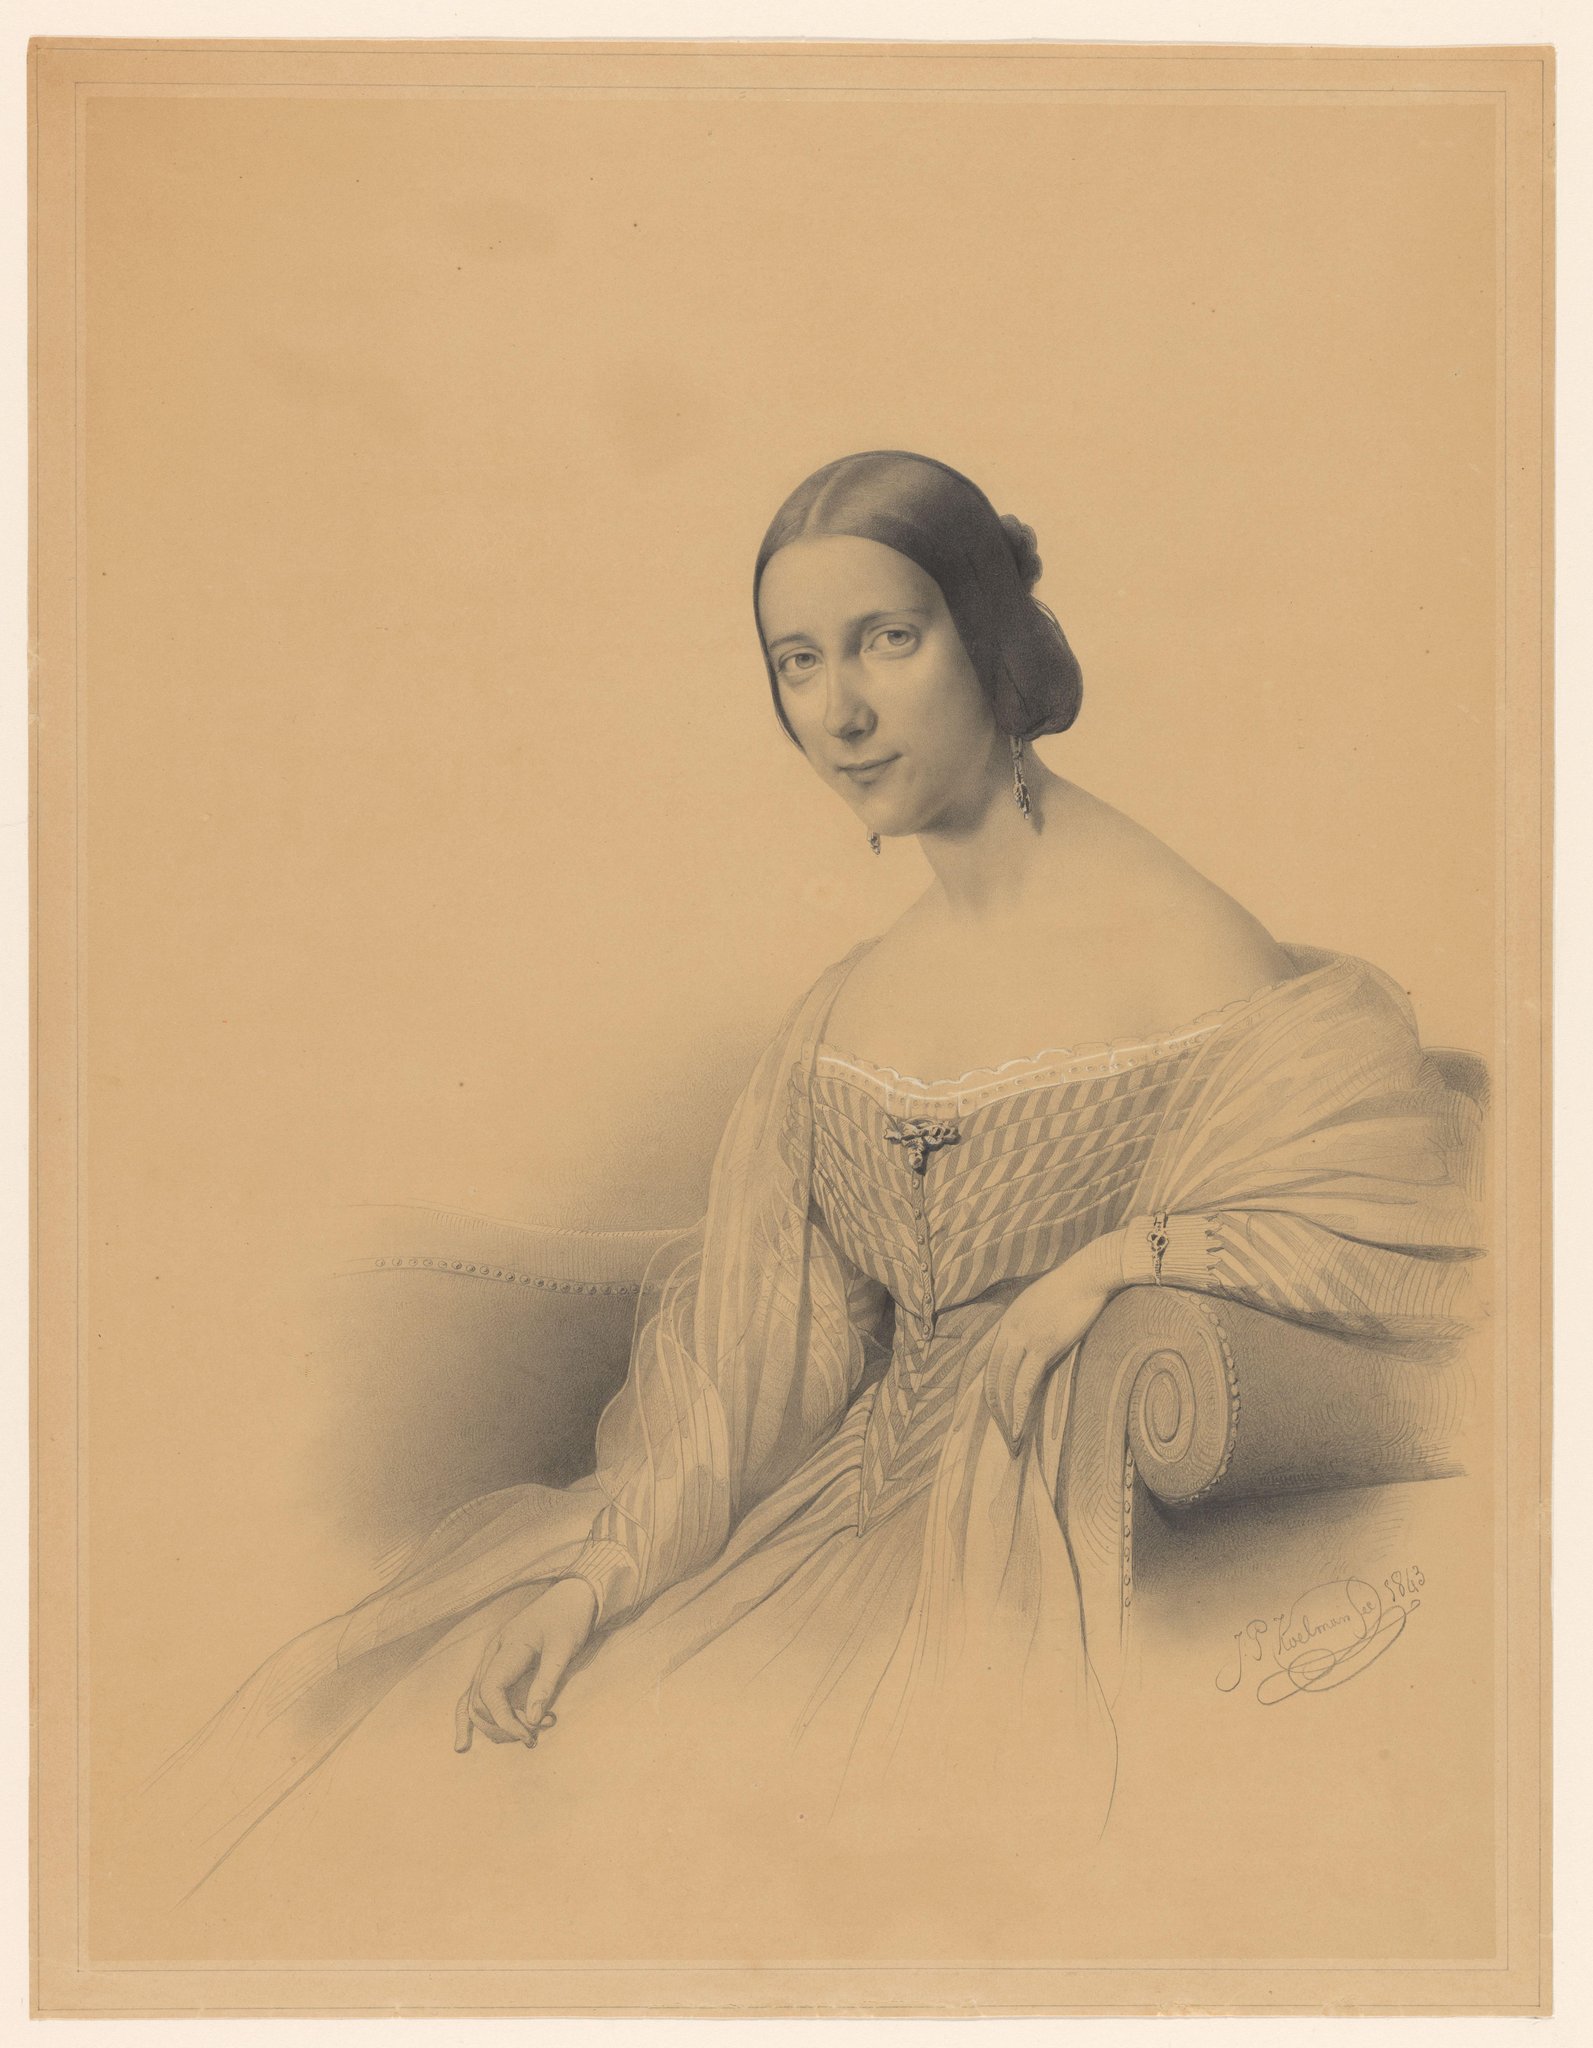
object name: drawing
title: Portret van Catherina Daniela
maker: johan philip koelman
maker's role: draughtsman, painter, print maker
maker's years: 1818-1893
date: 1843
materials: paint, pencil, paper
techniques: stumping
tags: historical persons - bb - woman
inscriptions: signature and date: ‘J.P.Koelman fec 1843’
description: Pendant van een portret van haar echtgenoot, Jhr. J.G.H. van Tets. In: Krabbels en kapitale tekeningen, nr. 234